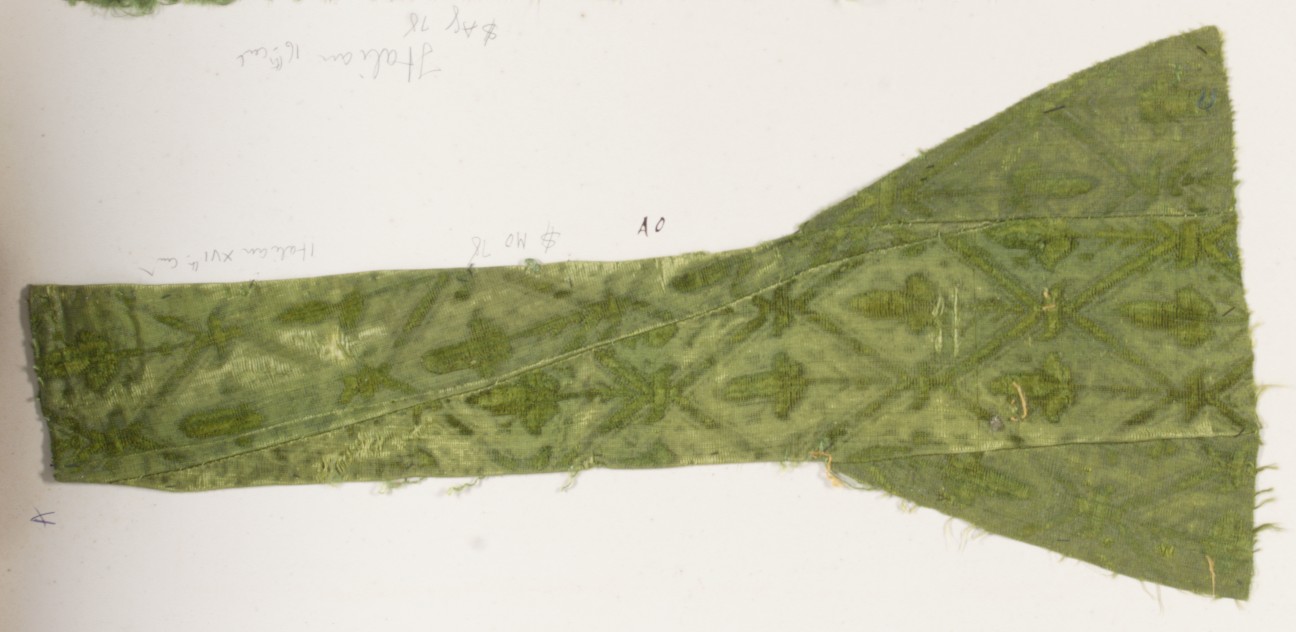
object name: fragment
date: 1501-1600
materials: silk